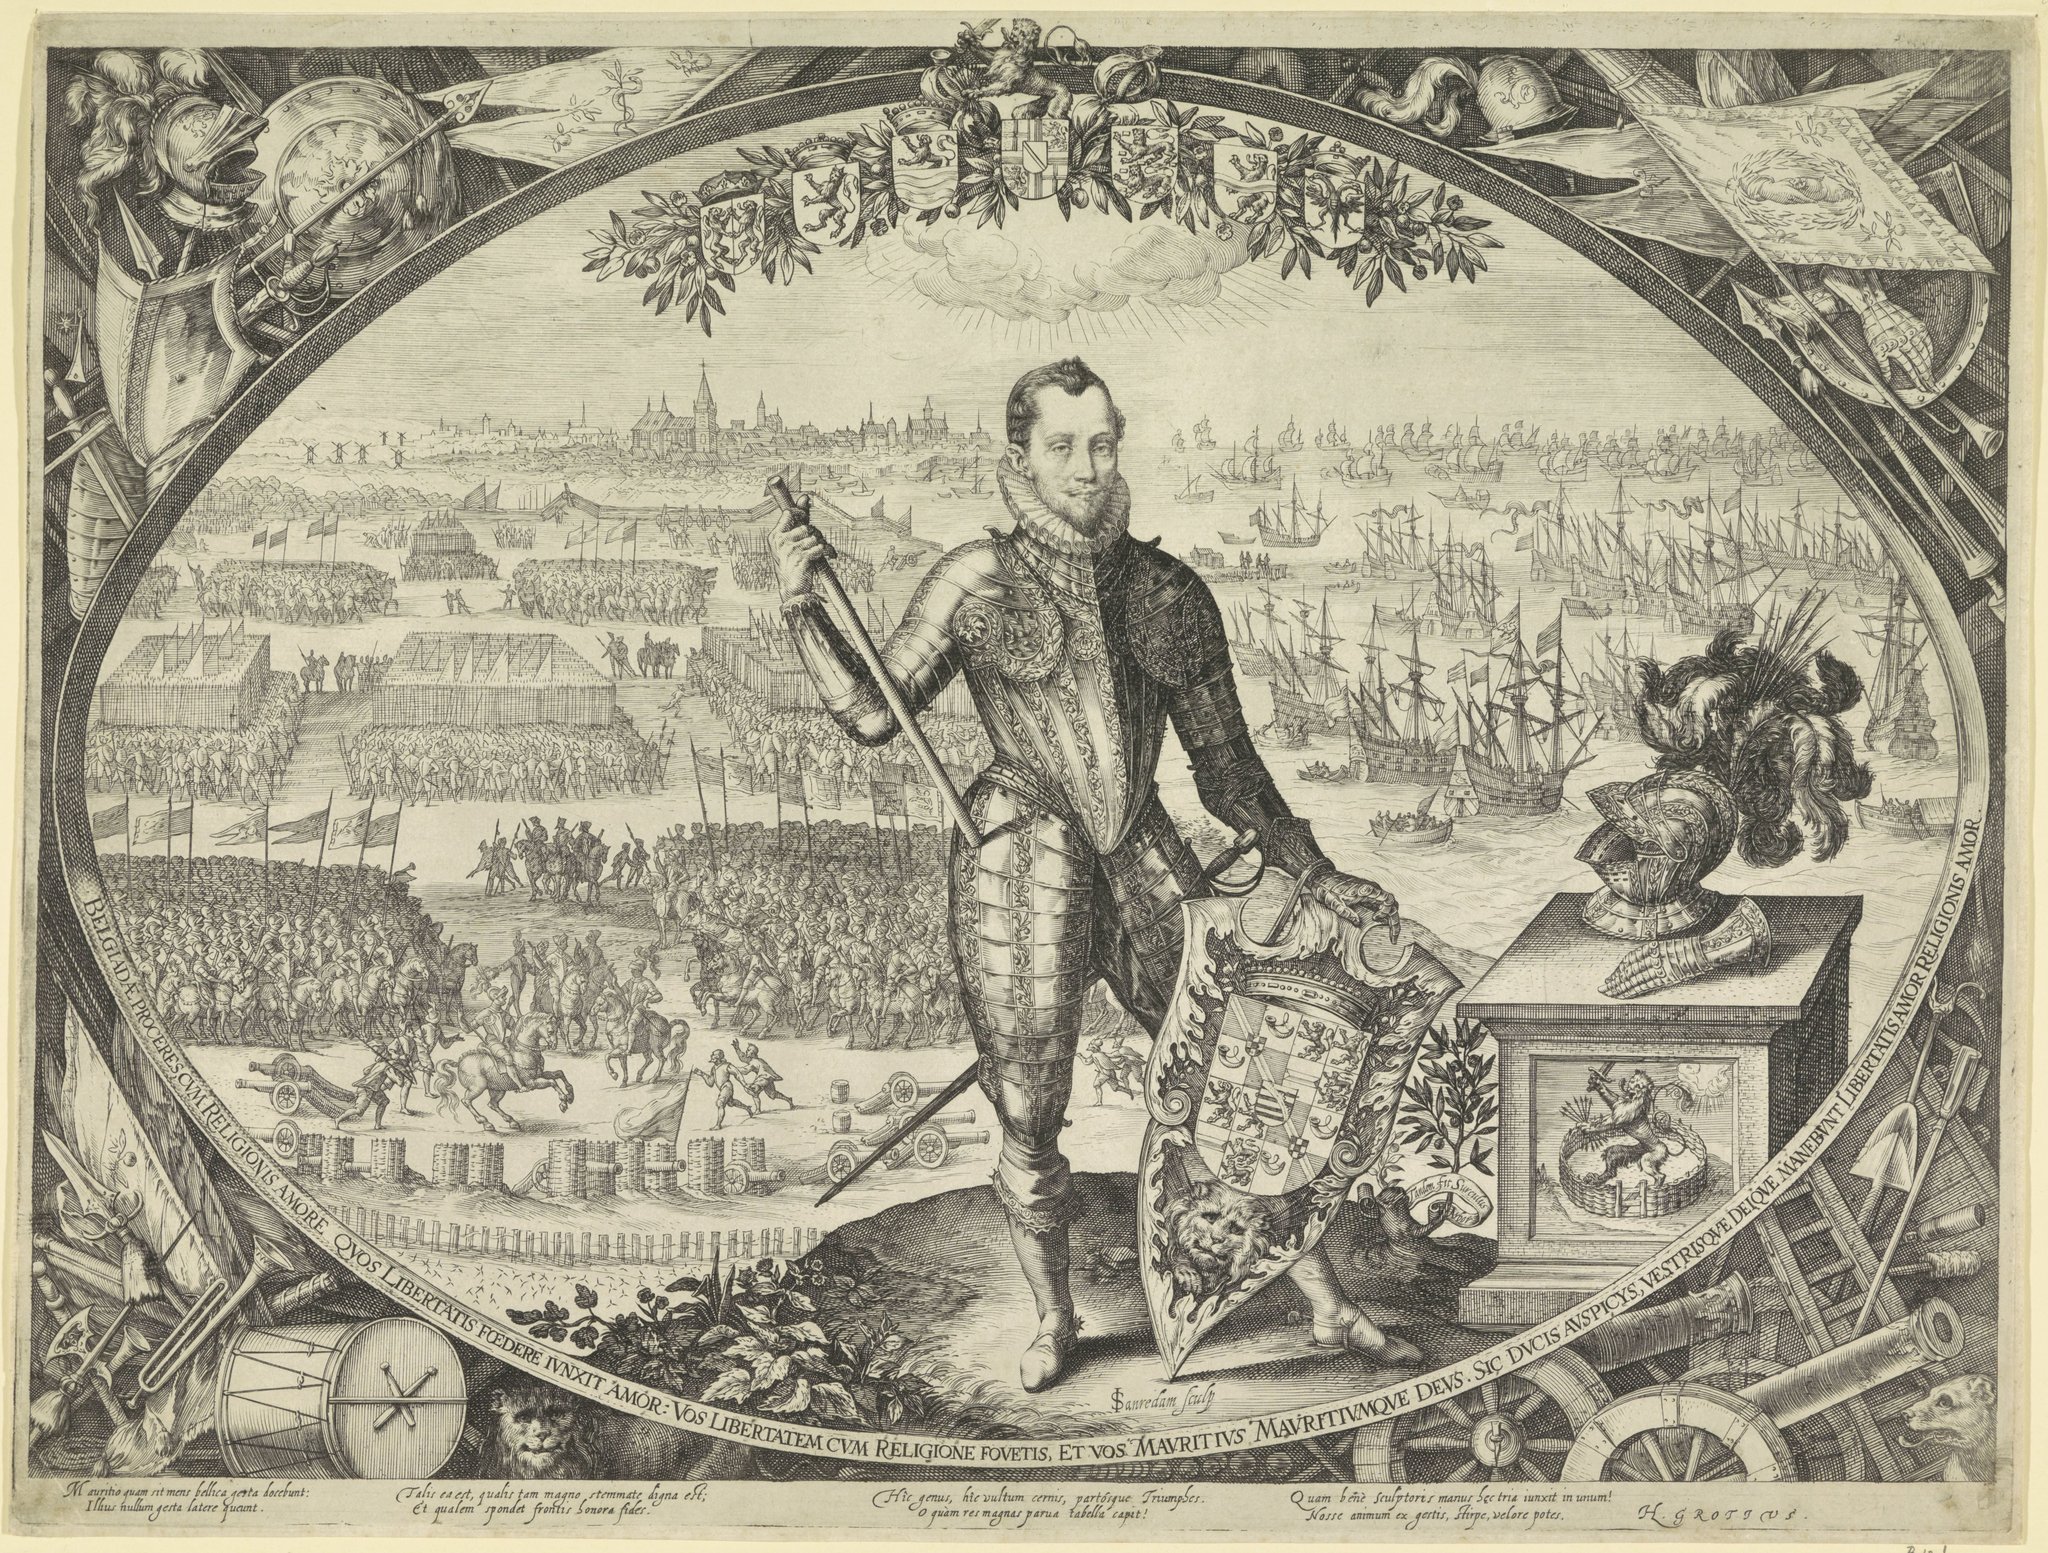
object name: print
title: Portret van Maurits, prins van Oranje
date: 1600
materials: paper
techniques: engraving, etching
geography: northern netherlands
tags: the hague, maurice (prince of orange)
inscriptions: collector's mark: Lugt 963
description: Portret van Maurits staande voor een landschap waarin te troepen van de prins bij Philippine aan land gaan. In de verte de stad, daarvoor de vesting (Grand Fort Philippe). Ovale voorstelling met in de hoeken vaandels, enkele dieren en allerlei wapentuig. Onder de prent een Latijns vers door Hugo de Groot.